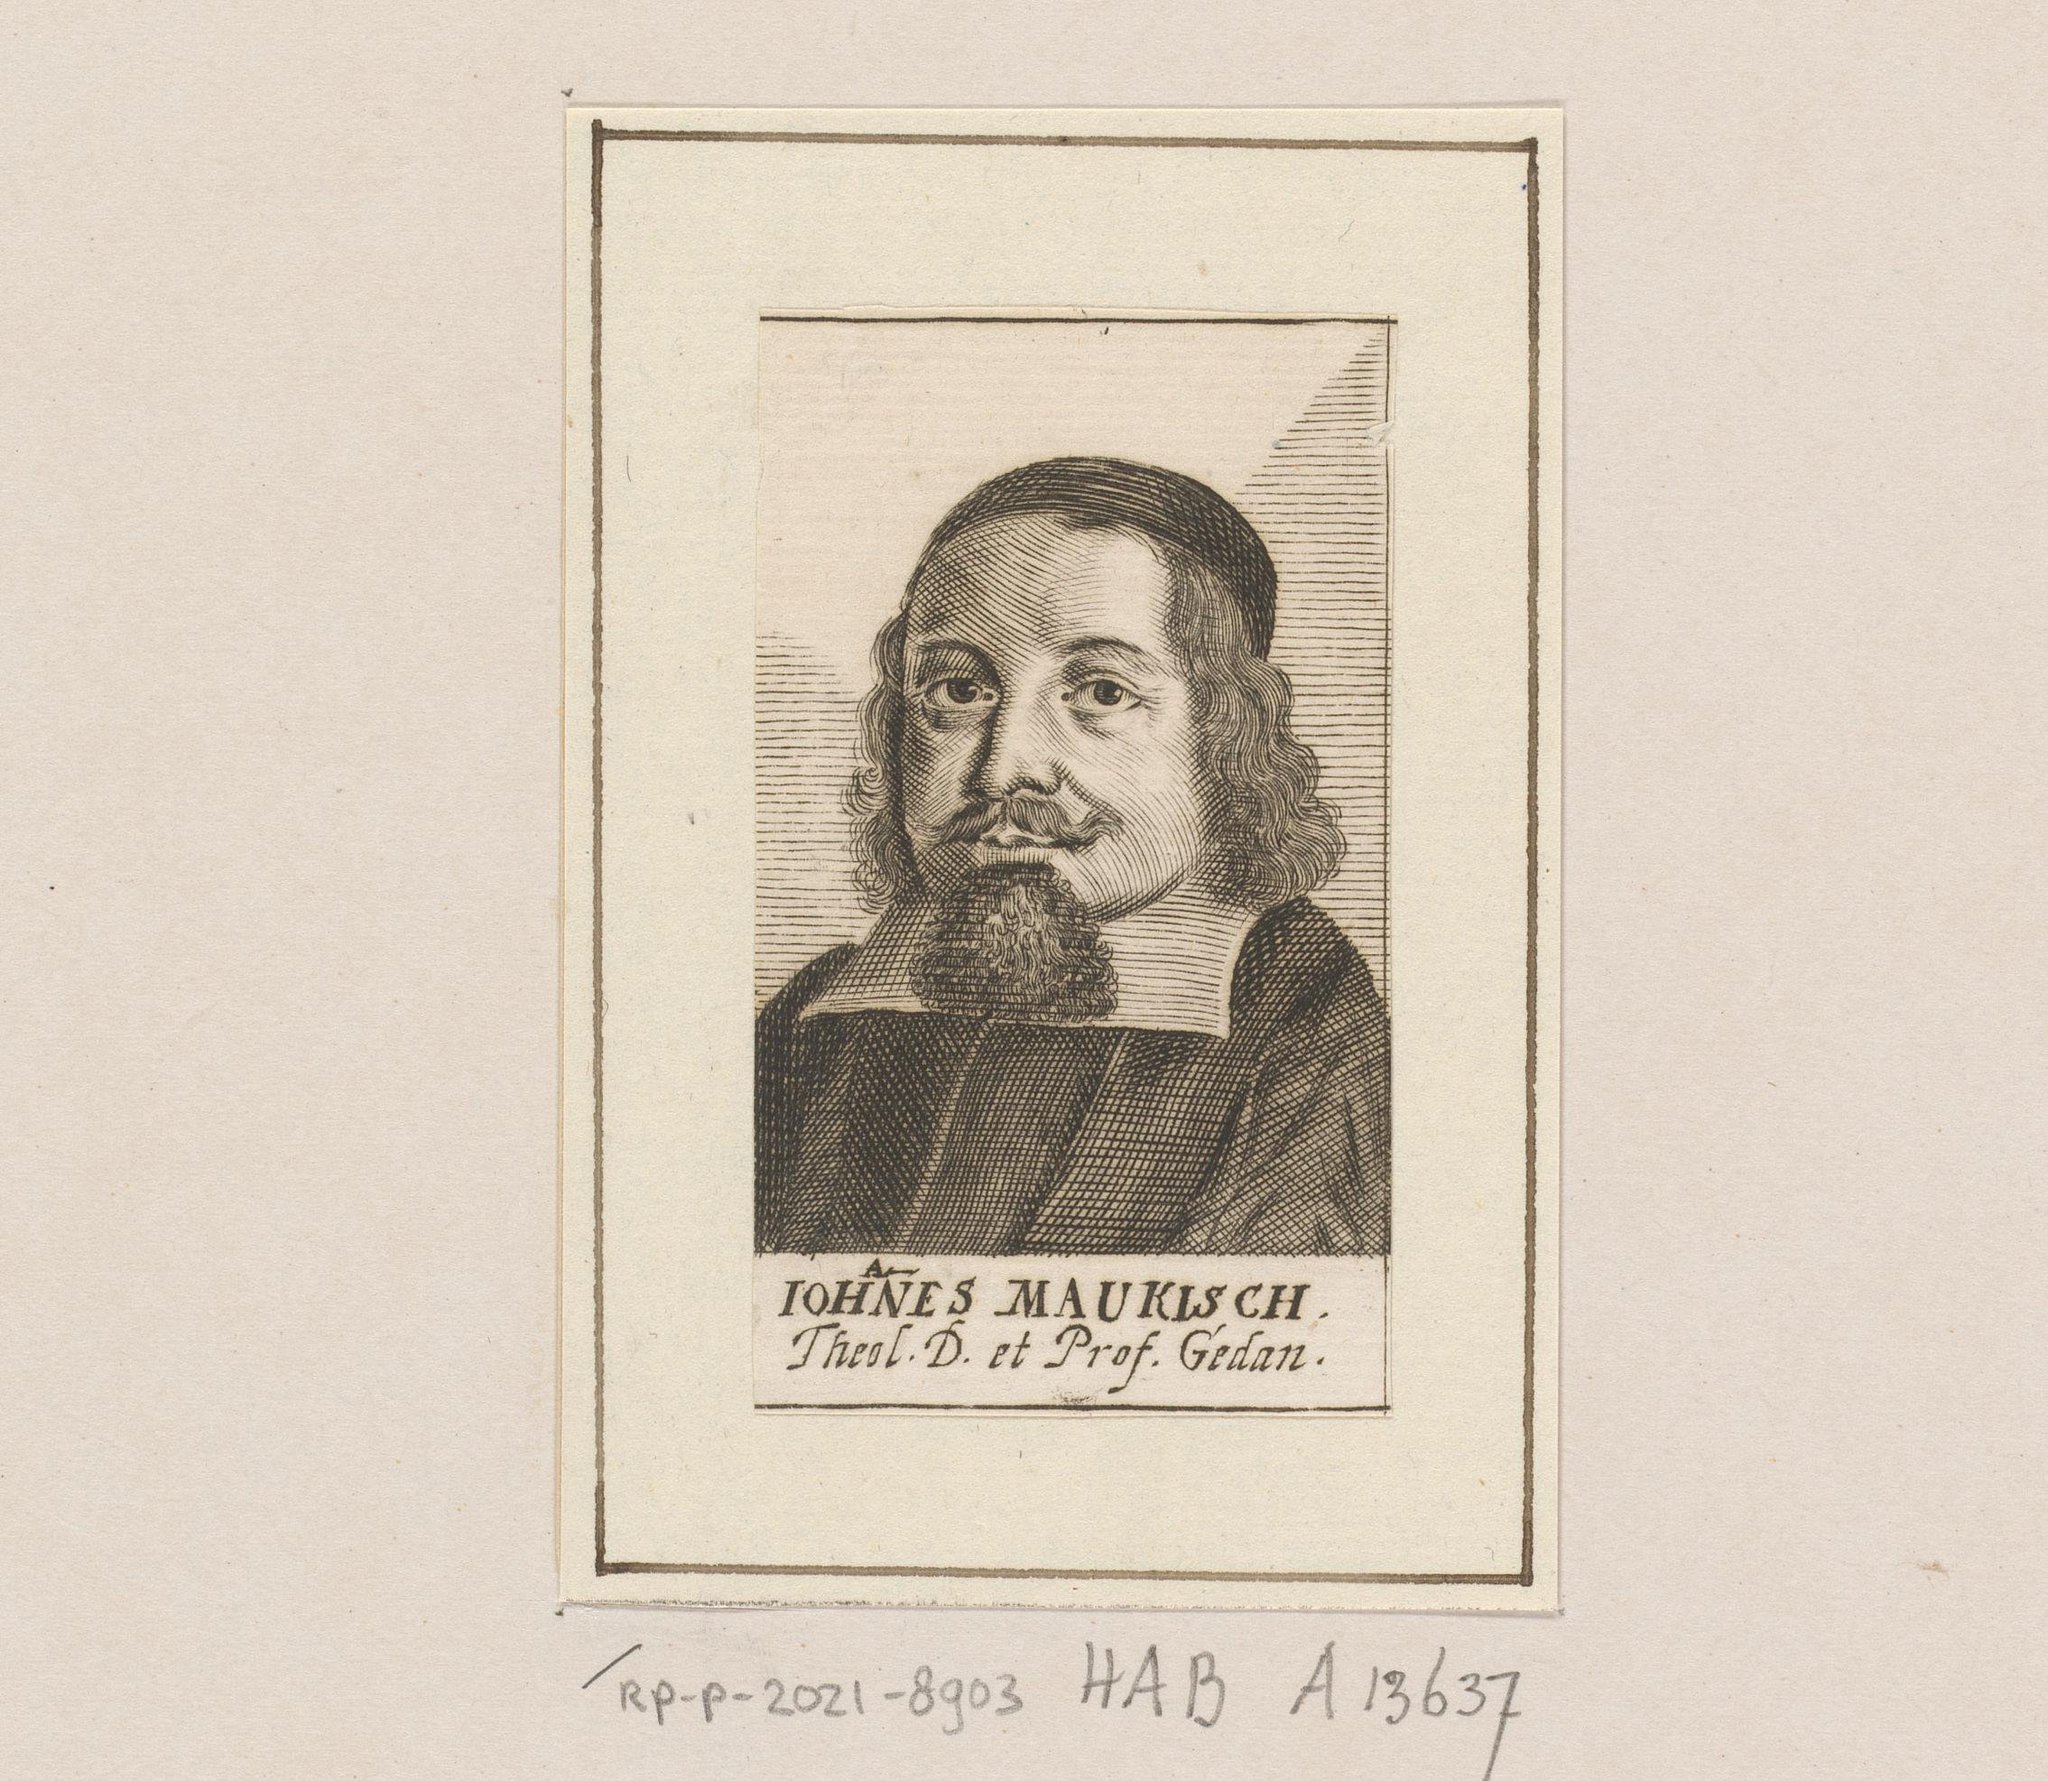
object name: print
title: Portret van Johann Maukisch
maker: johann franck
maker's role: print maker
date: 1688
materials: paper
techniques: engraving, snipping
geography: germany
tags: theologian, historical persons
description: Prent waarschijnlijk uit: Freher, Paul. Theatrum virorum eruditione clarorum. Neurenberg: Johann Hoffmann, 1688.